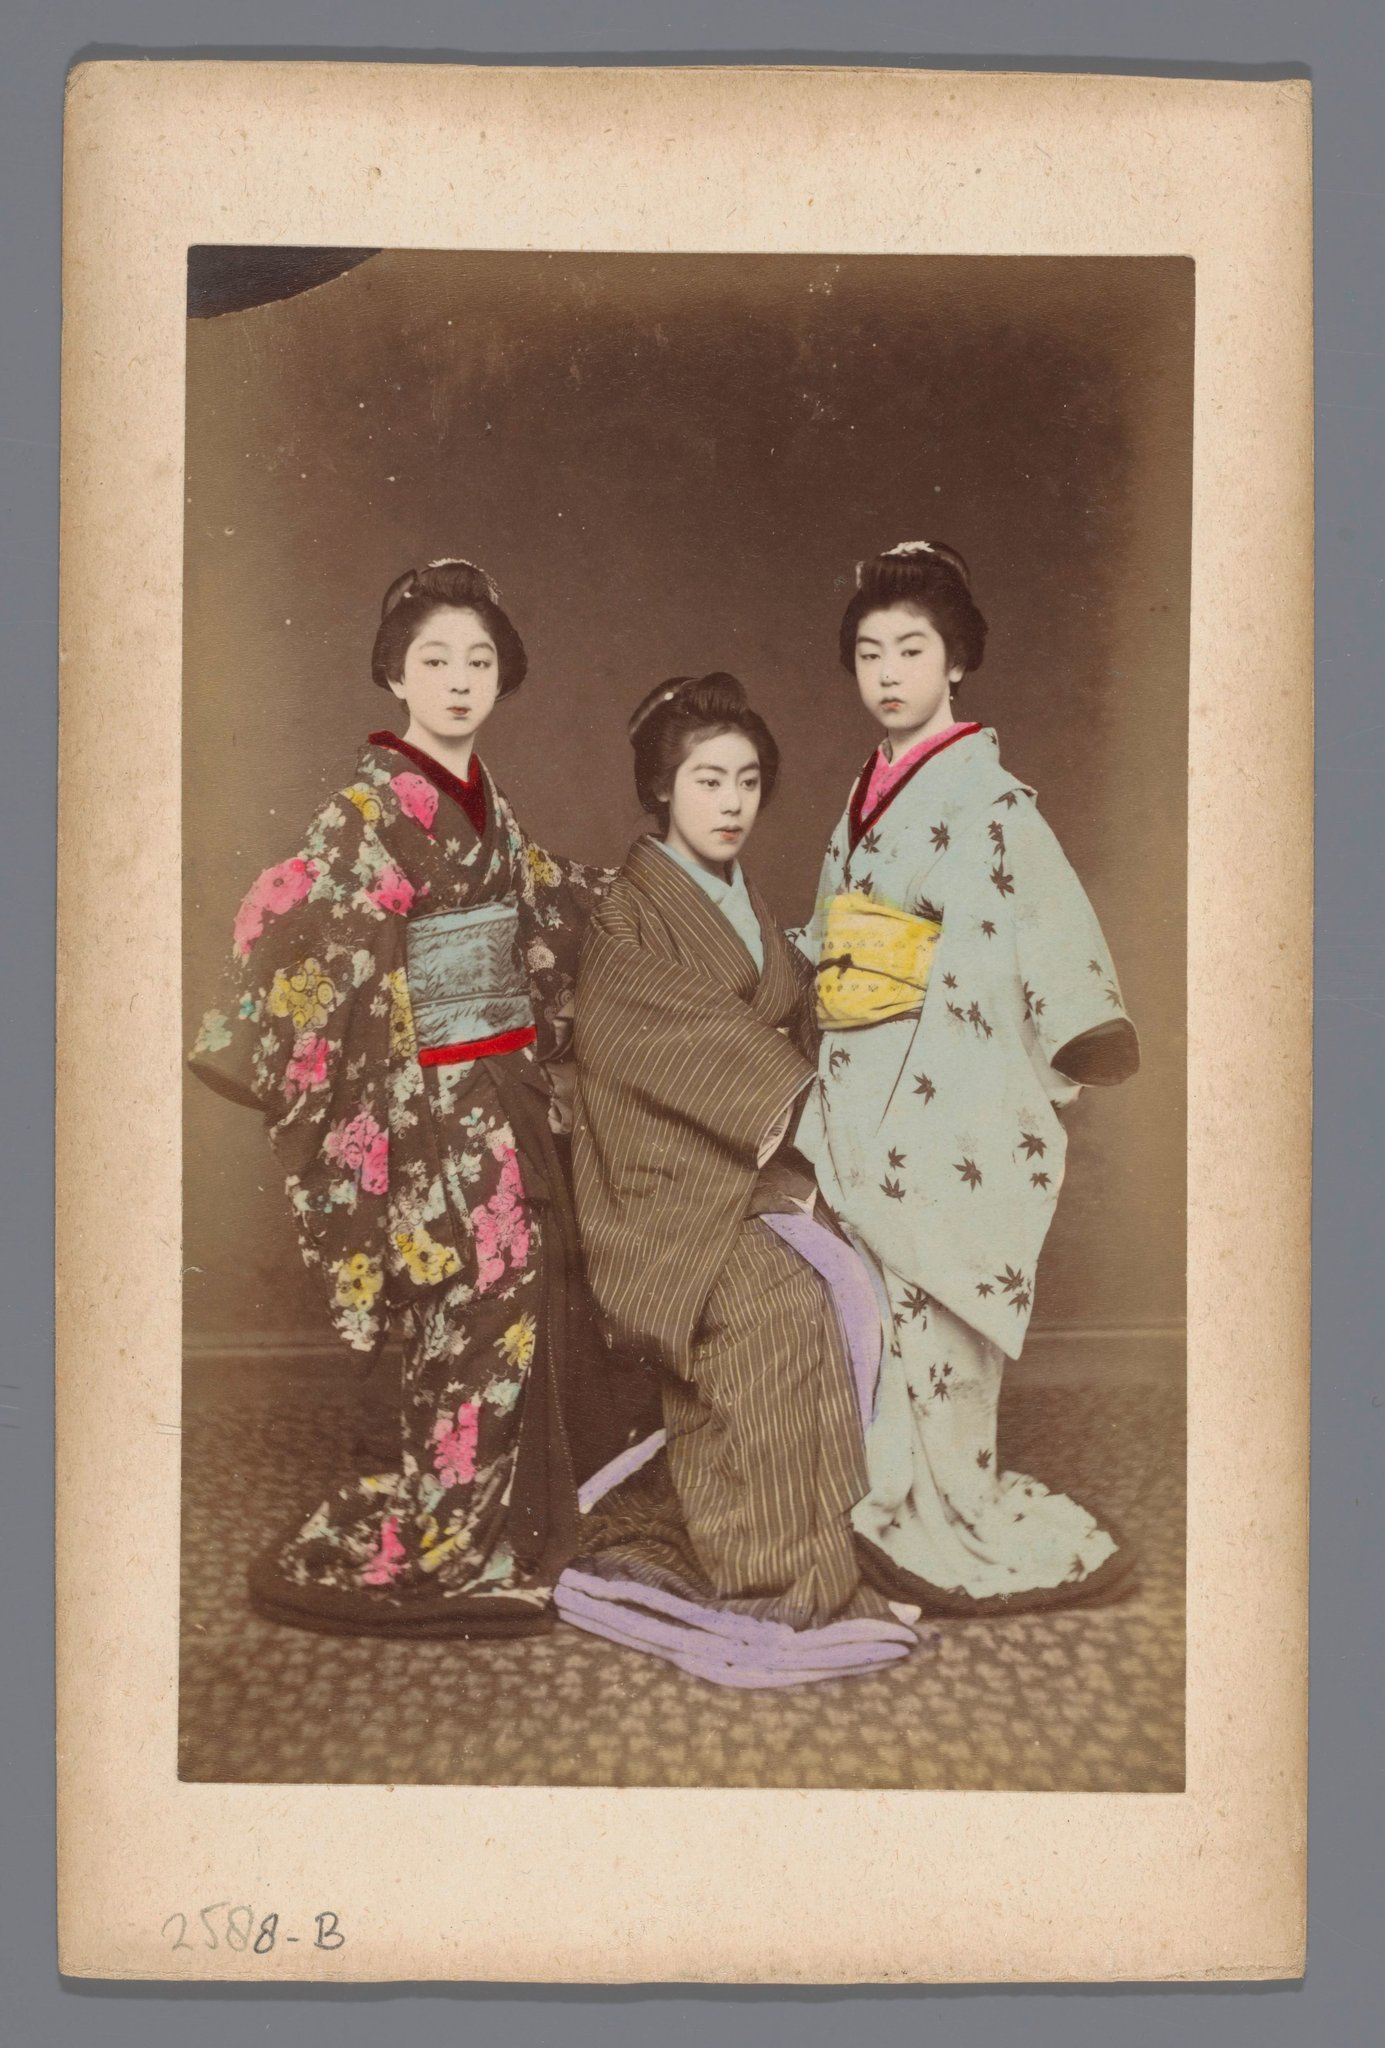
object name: photograph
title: Groepsportret van drie onbekende Japanse meisjes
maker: Anonymous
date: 1860-1900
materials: cardboard, paper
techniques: albumen print, hand coloring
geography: japan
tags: anonymous historical persons portrayed in a group, in a group-portrait - bb - woman, japan